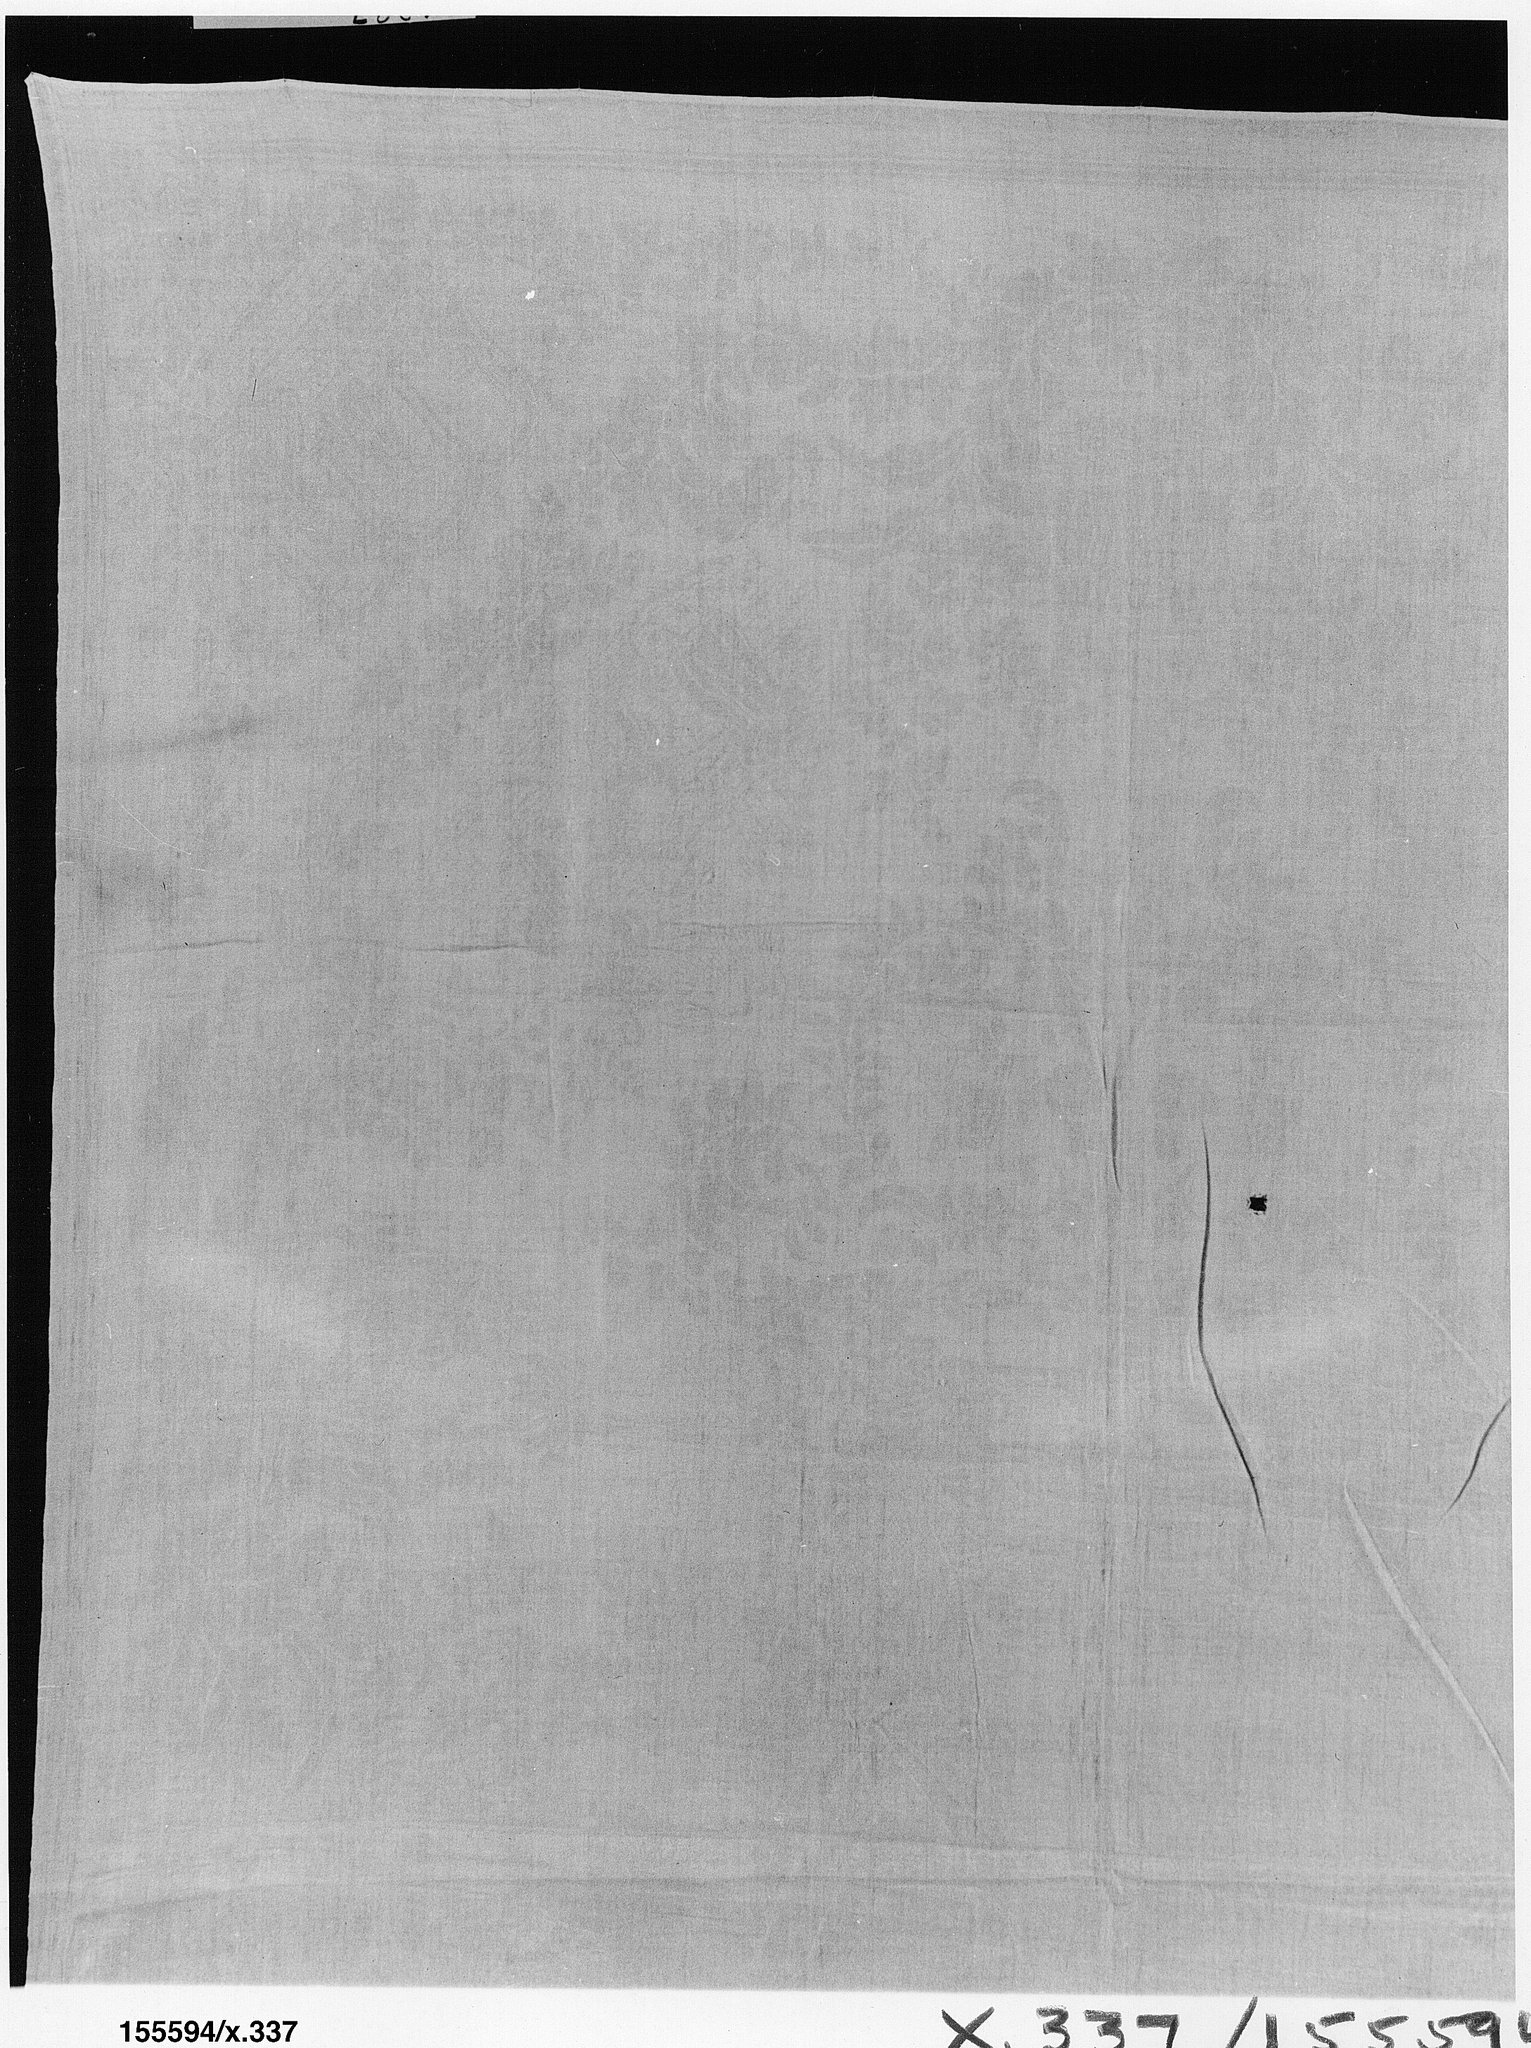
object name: tablecloth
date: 1834-1866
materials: linen